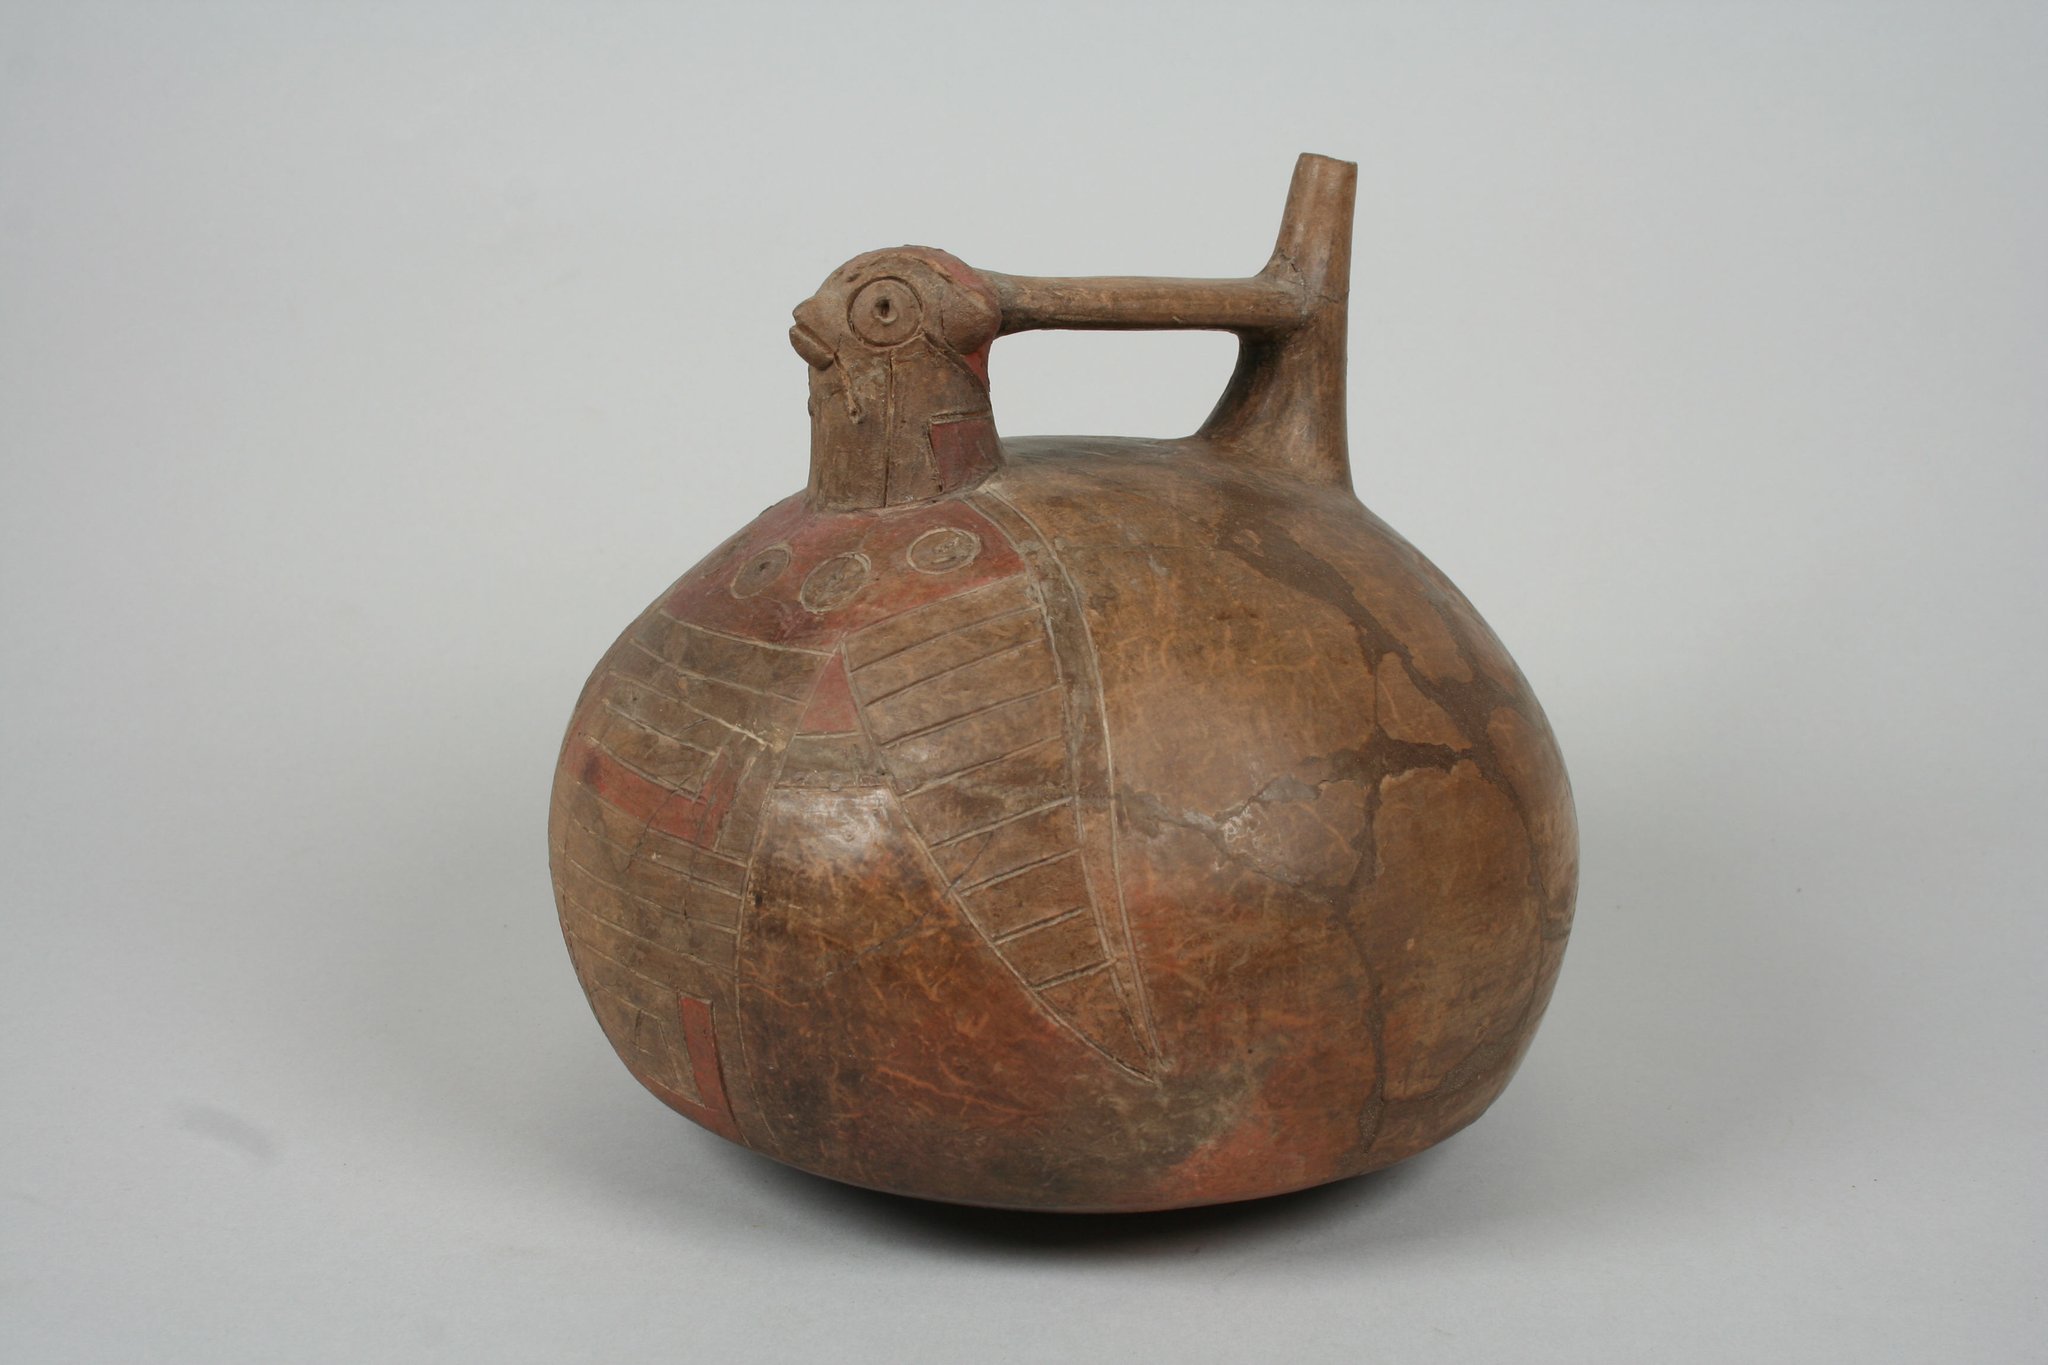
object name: bottle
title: Bottle, Falcon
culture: paracas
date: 400-201 BCE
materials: ceramic, pigment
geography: peru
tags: falcons